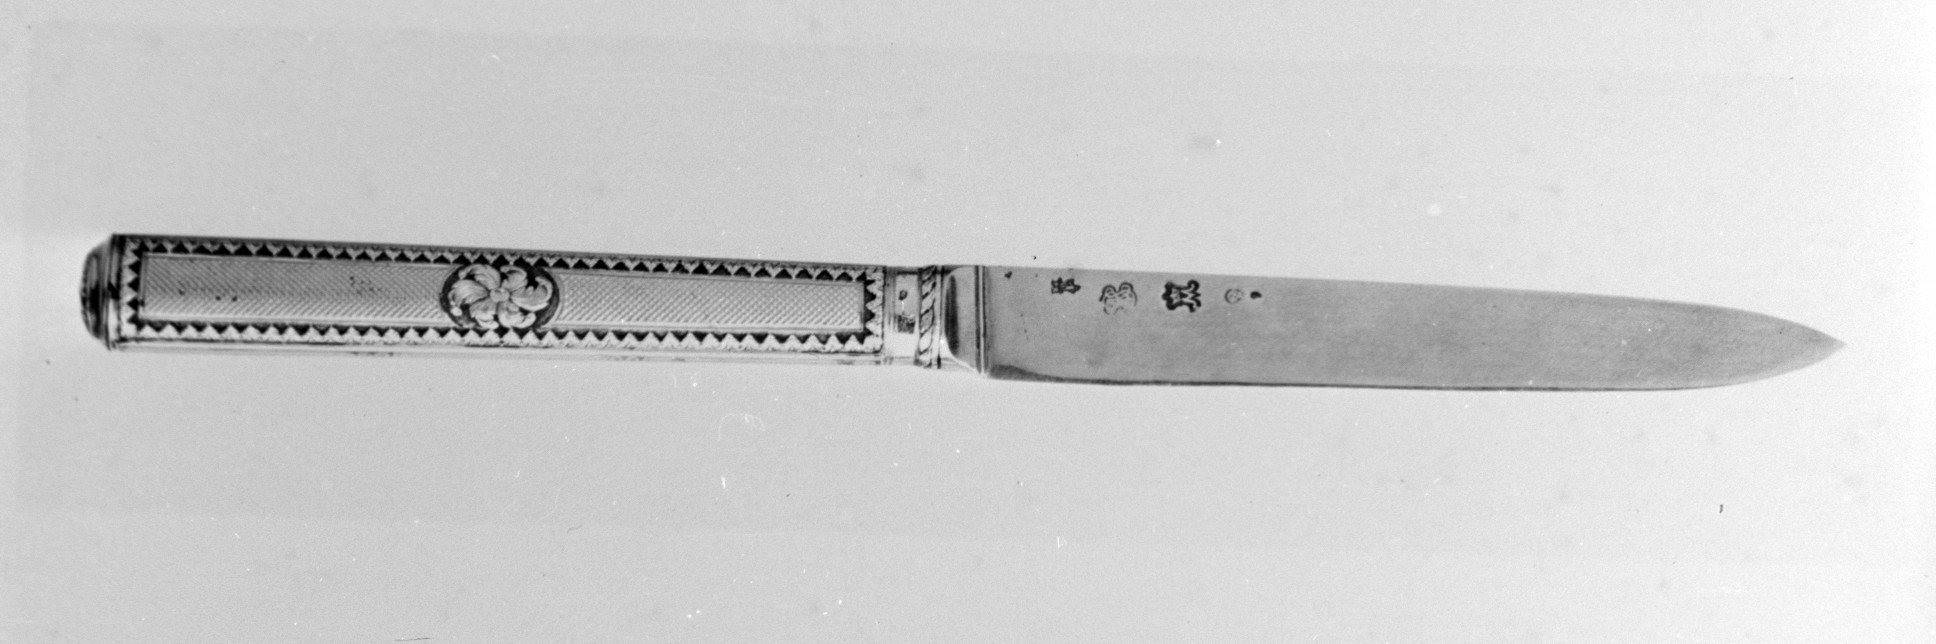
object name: knife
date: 1775-1776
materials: gold